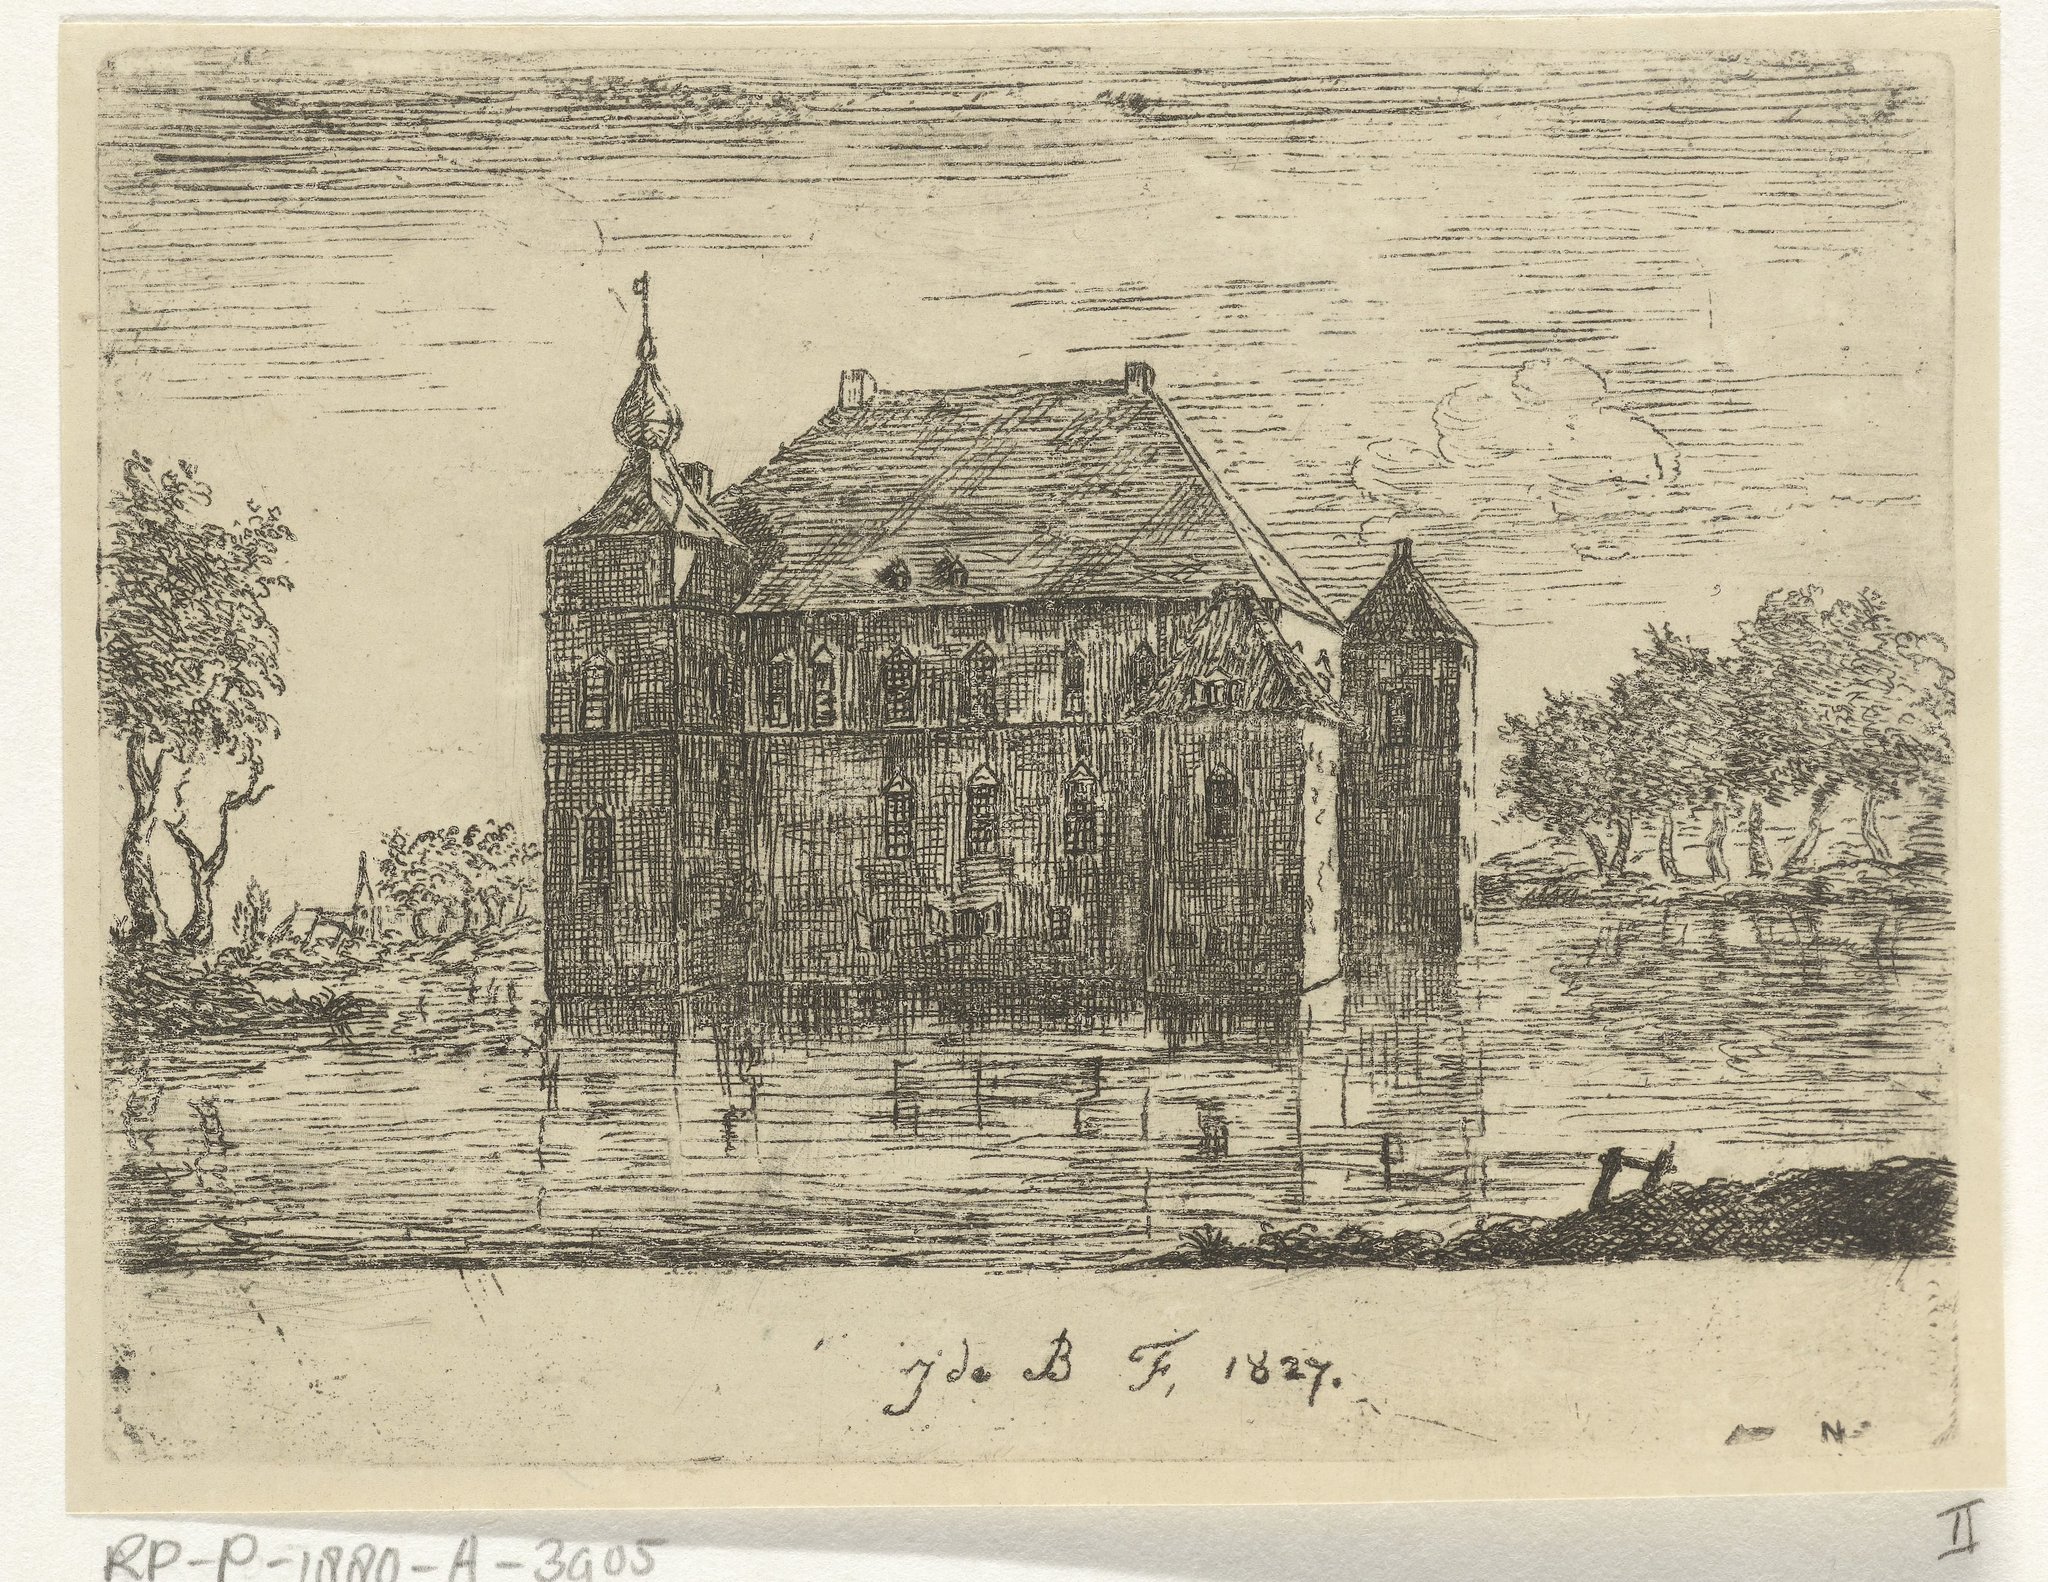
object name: print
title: Kasteel de Cannenburch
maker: reinierus albertus ludovicus baron van isendoorn à blois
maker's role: print maker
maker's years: 1786-1856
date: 1827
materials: paper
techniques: etching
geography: vaassen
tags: castle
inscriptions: collector's mark: Lugt 2228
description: Kasteel de Cannenburch te Vaassen van de achterkant gezien.